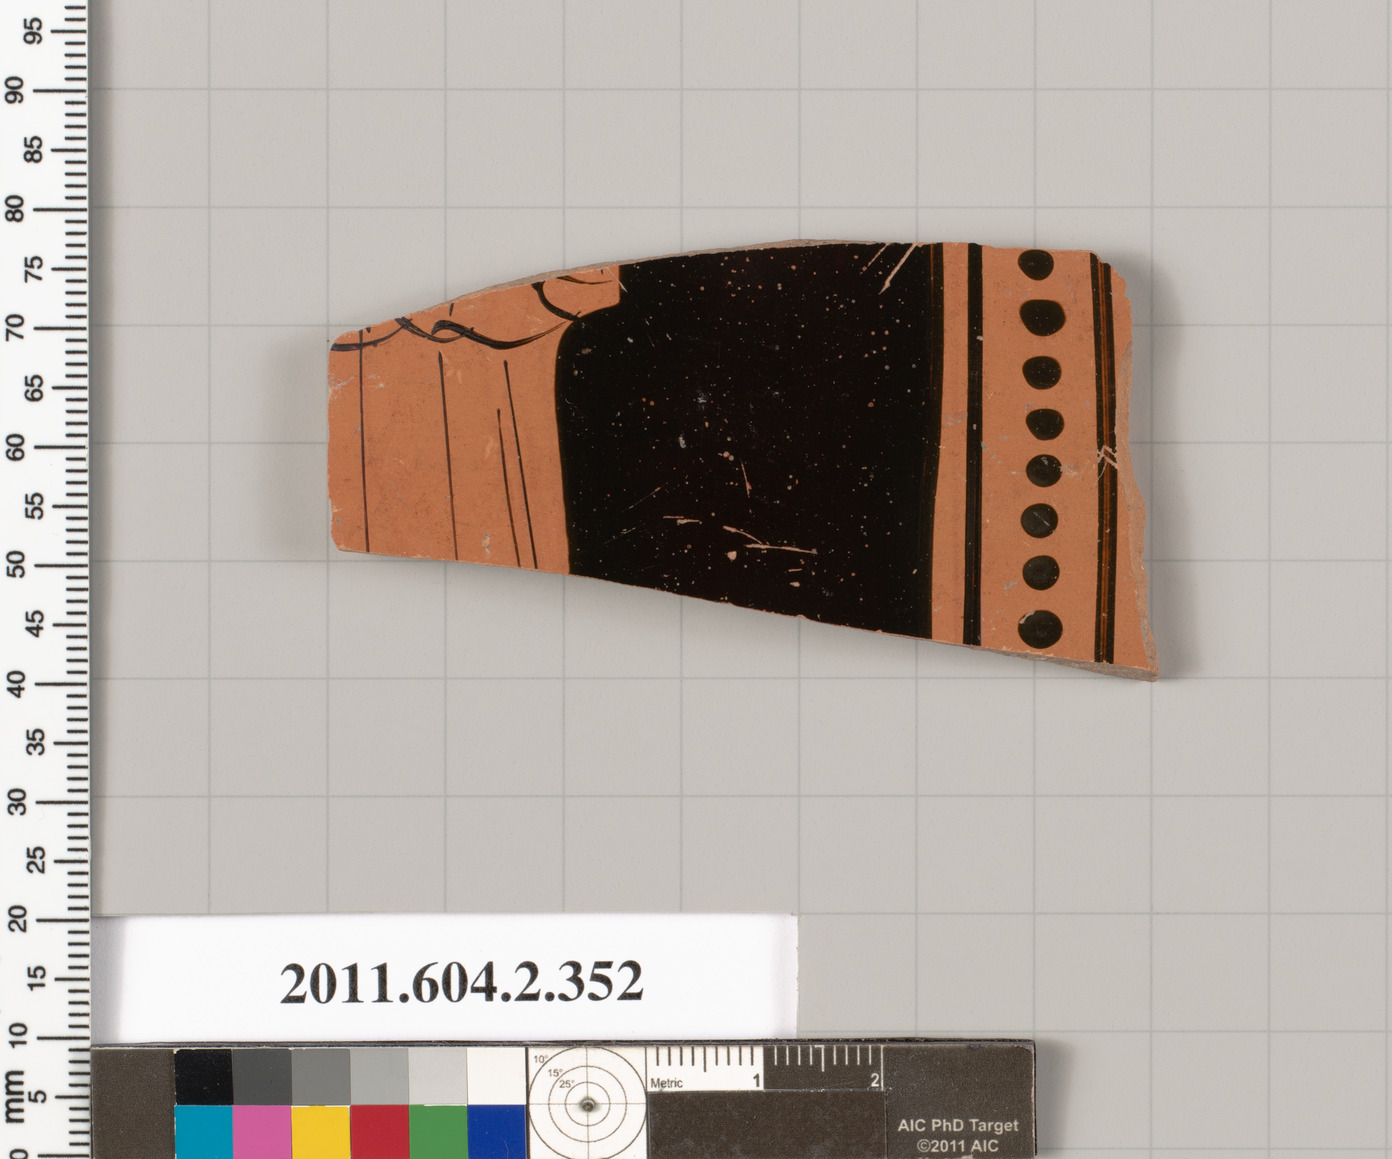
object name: column krater fragment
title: Terracotta fragment of a column-krater (bowl for mixing wine and water)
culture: greek, attic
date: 450-440 BCE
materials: terracotta